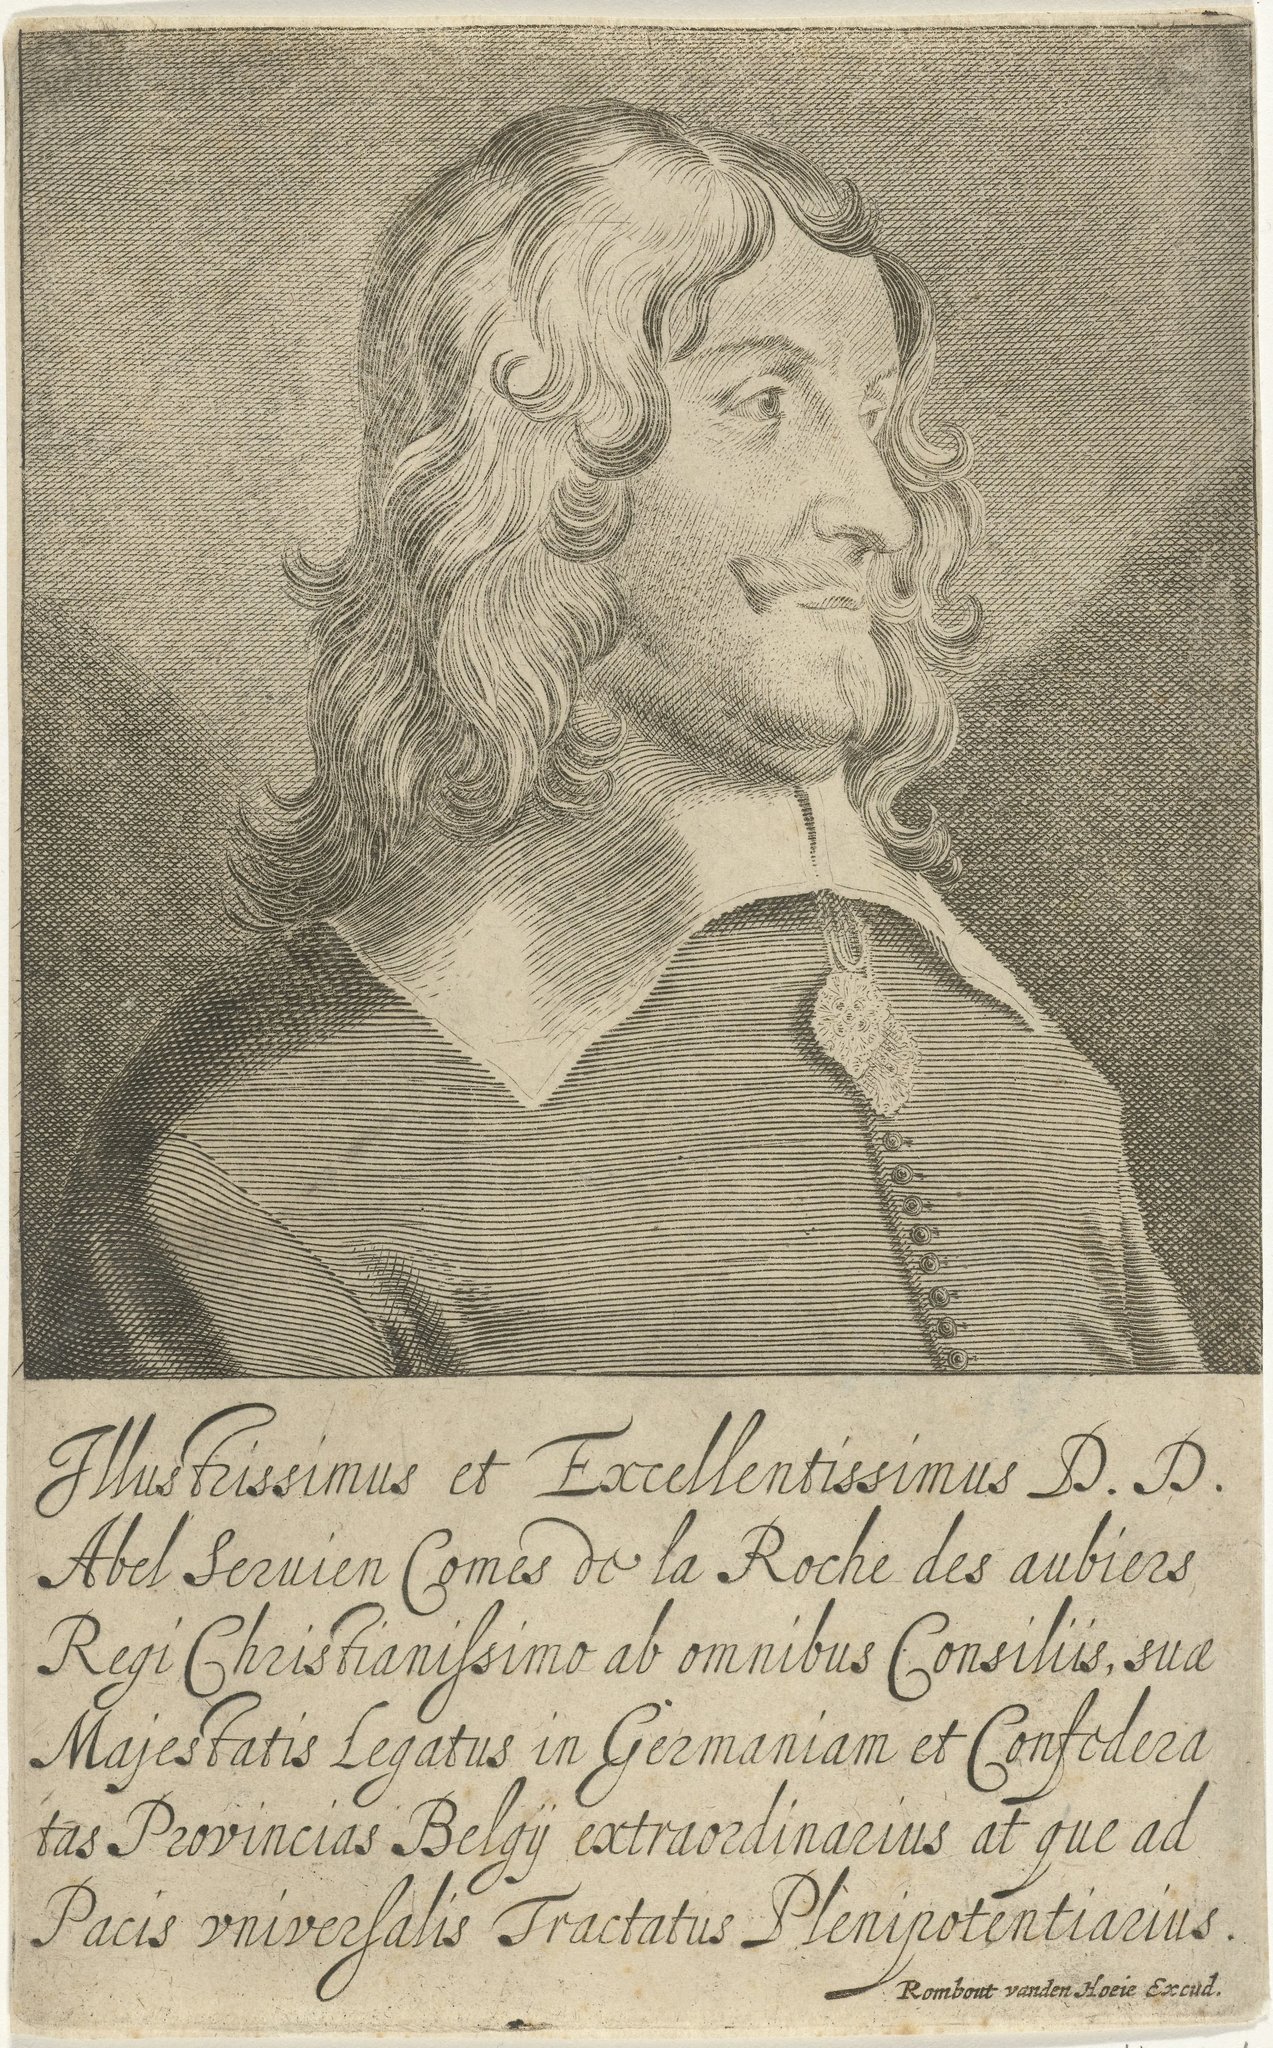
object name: print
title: Portret van Abel de Servien, Graaf de la Roche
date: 1648-1664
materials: paper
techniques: engraving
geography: amsterdam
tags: grenoble, meudon, abel de servien (graaf de la roche), vrede van münster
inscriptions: collector's mark: Lugt 2228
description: Buste naar rechts van Abel de Servien, graaf de la Roche. Onder het portret zes regels in het Latijn. Prent uit een serie portretten van ambassadeurs betrokken bij het vredesverdrag van Munster.